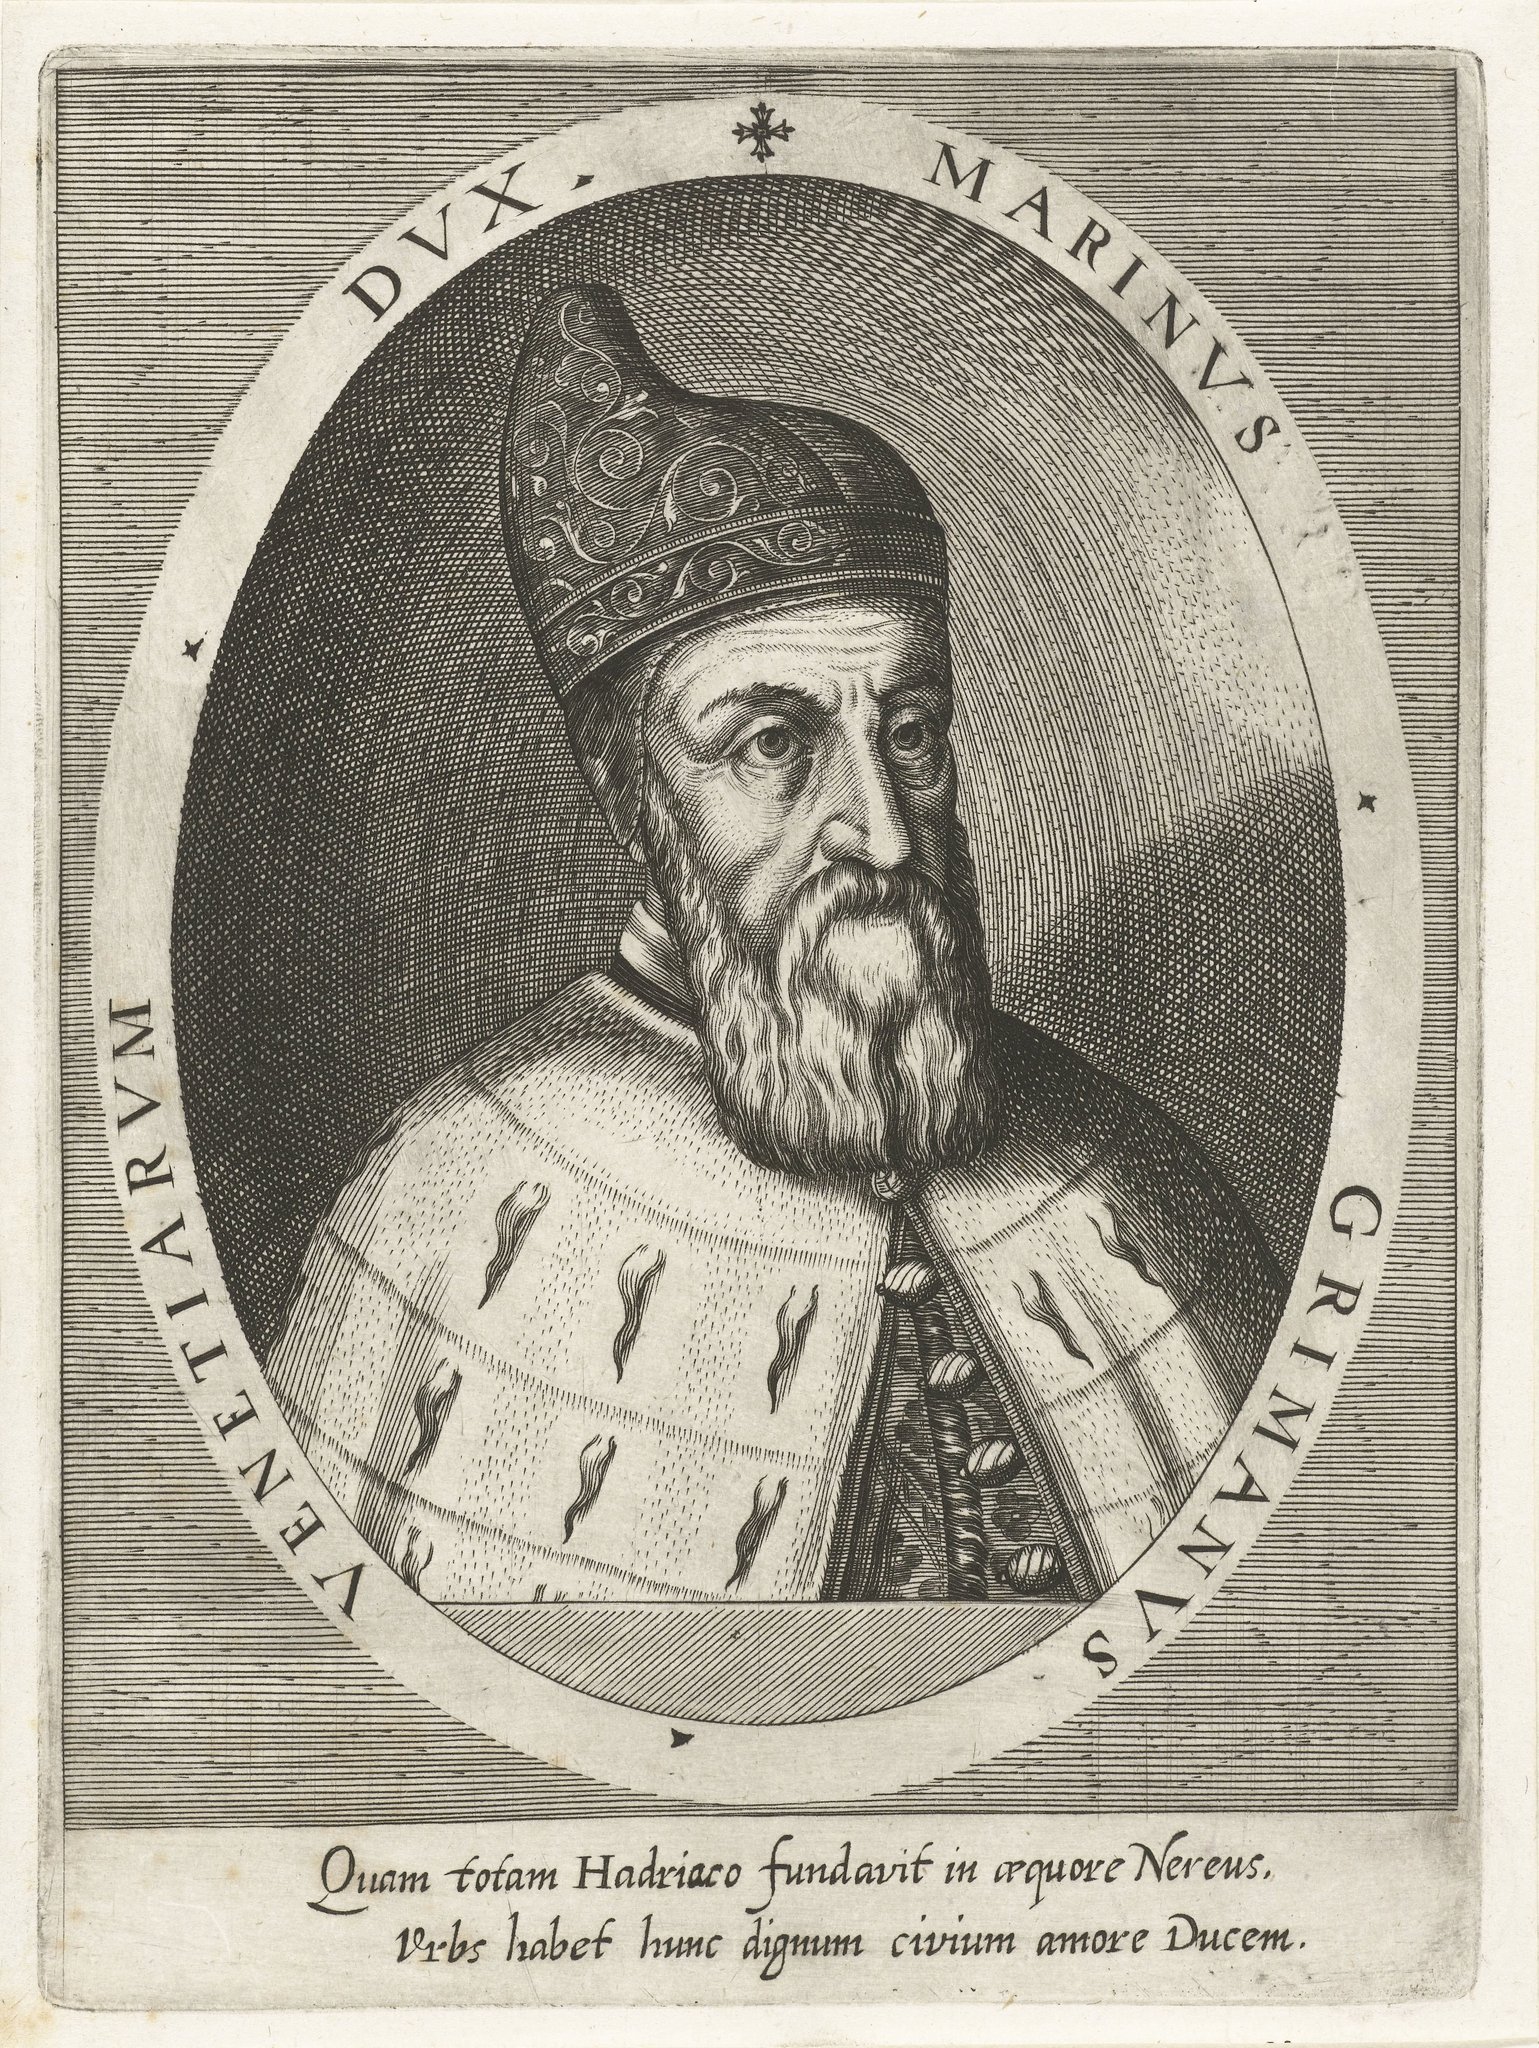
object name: print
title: Portret van Marino Grimani, doge van Venetië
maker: dominicus custos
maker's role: print maker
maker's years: 1560-1615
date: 1600-1604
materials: paper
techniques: engraving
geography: augsburg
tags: venice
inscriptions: collector's mark: Lugt 240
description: Illustratie uit: D. Custos en M. Henning. Atrium heroicum Caesarum, regum aliorq. summatum ac procerum qui intra proximum seculum vixere, aut hodie supersunt, imaginib. Deel 1-4. Augsburg: D. Custos, 1600-1604.